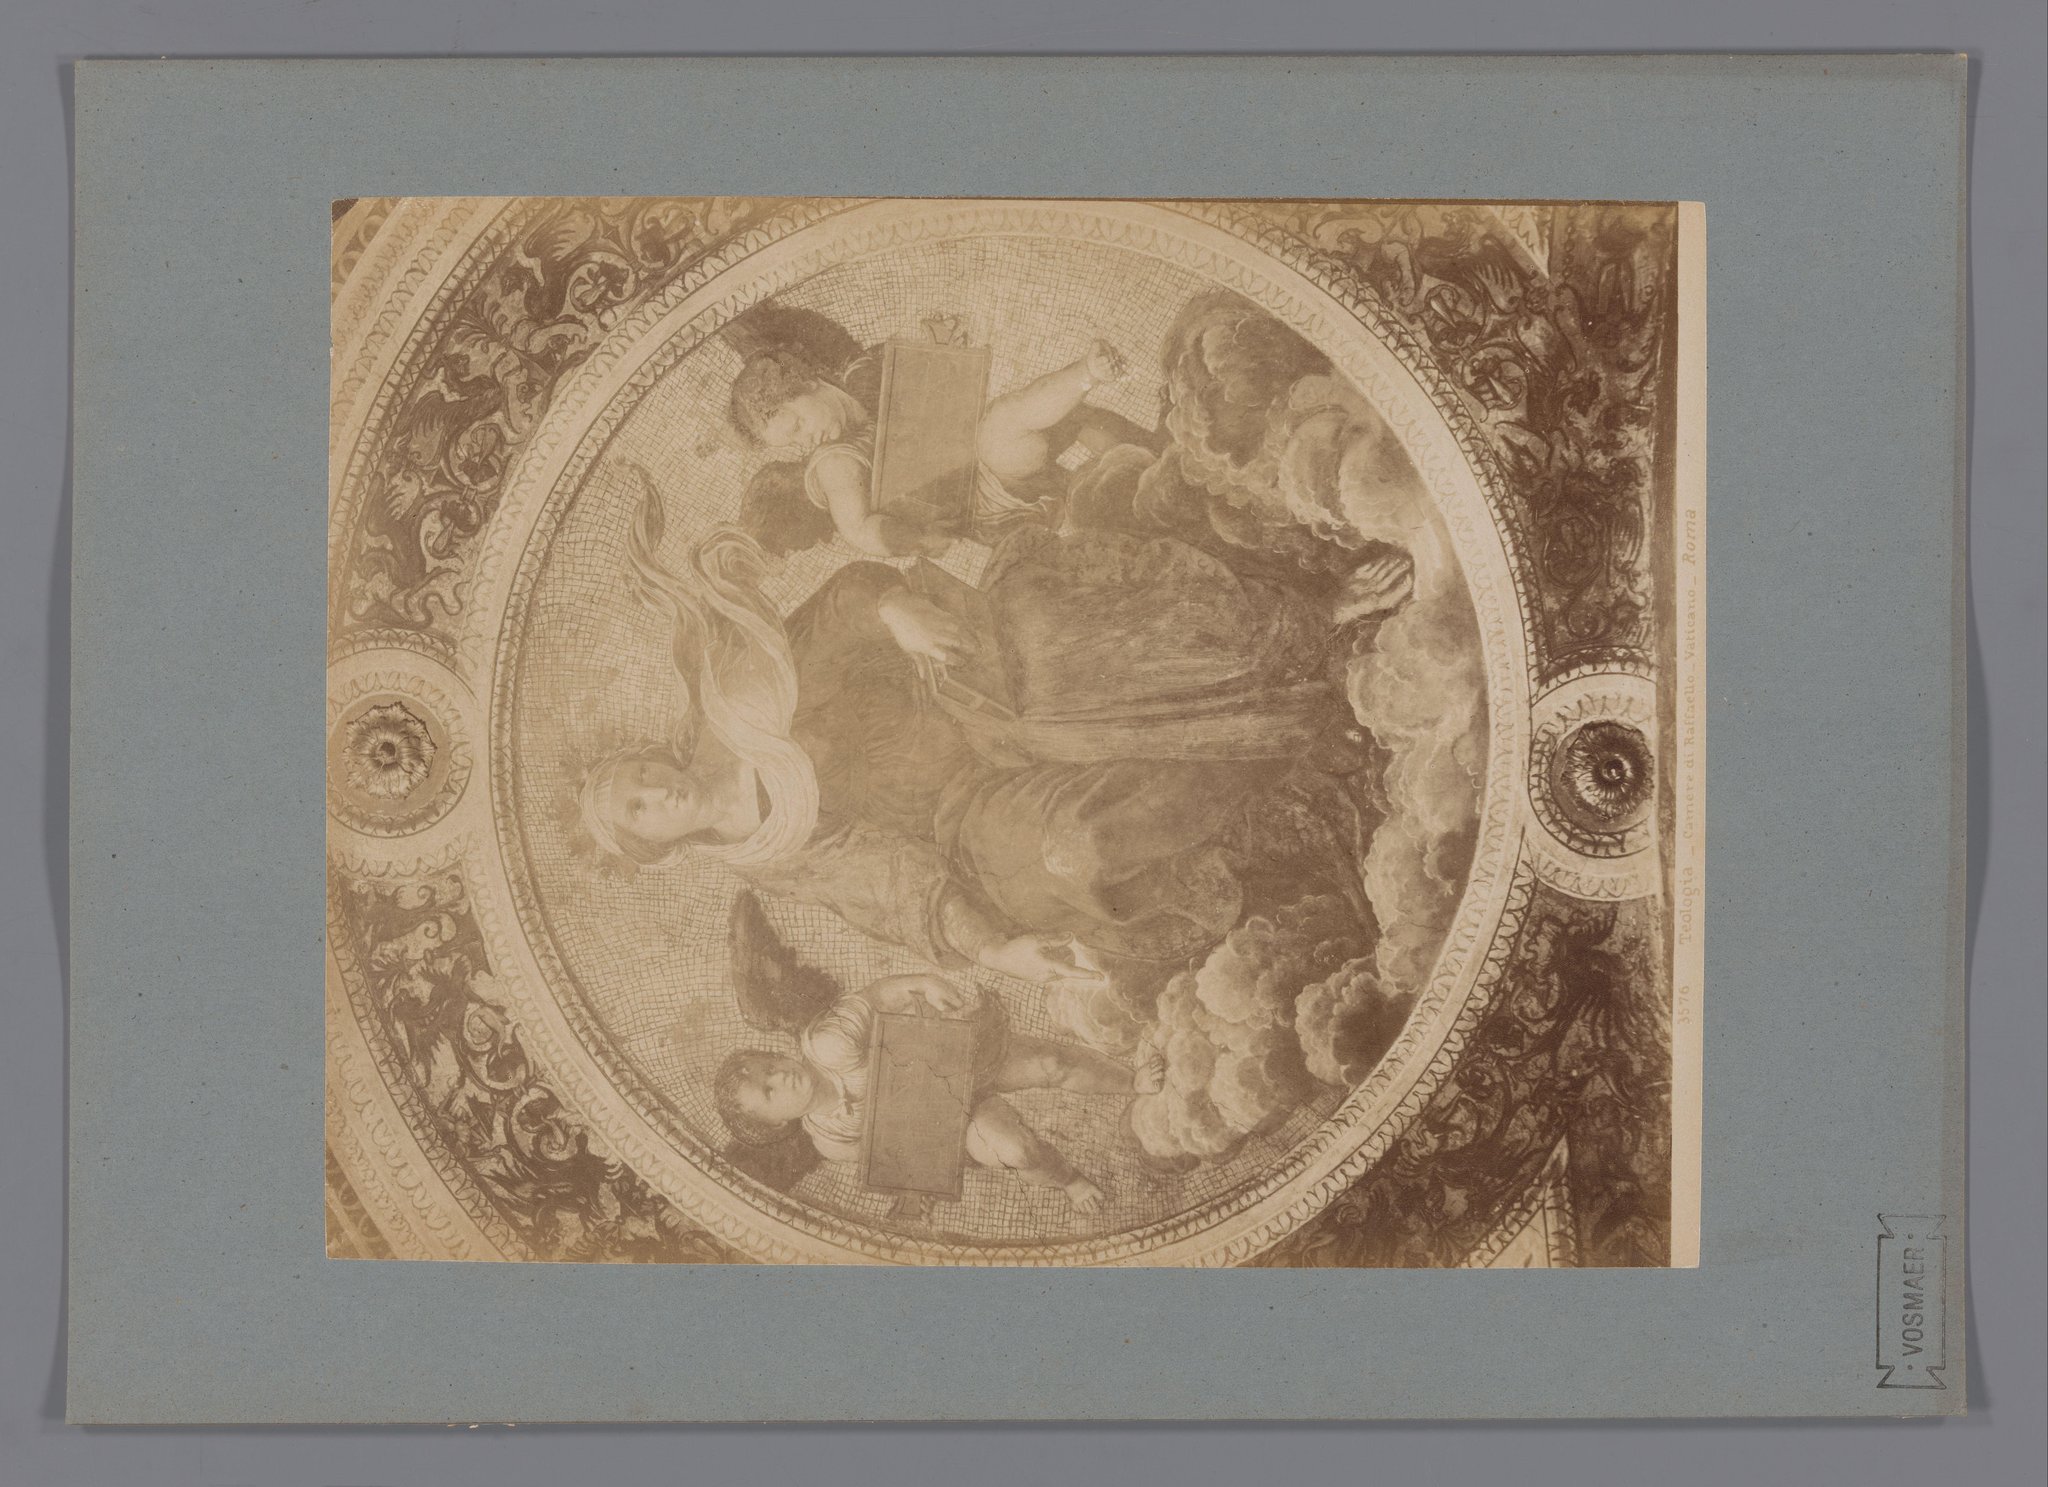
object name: reproduction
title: Roma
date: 1851-1900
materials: cardboard, paper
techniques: albumen print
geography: vatican city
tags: picture, painting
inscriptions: collector's mark: ‘VOSMAER’, number: ‘3576’